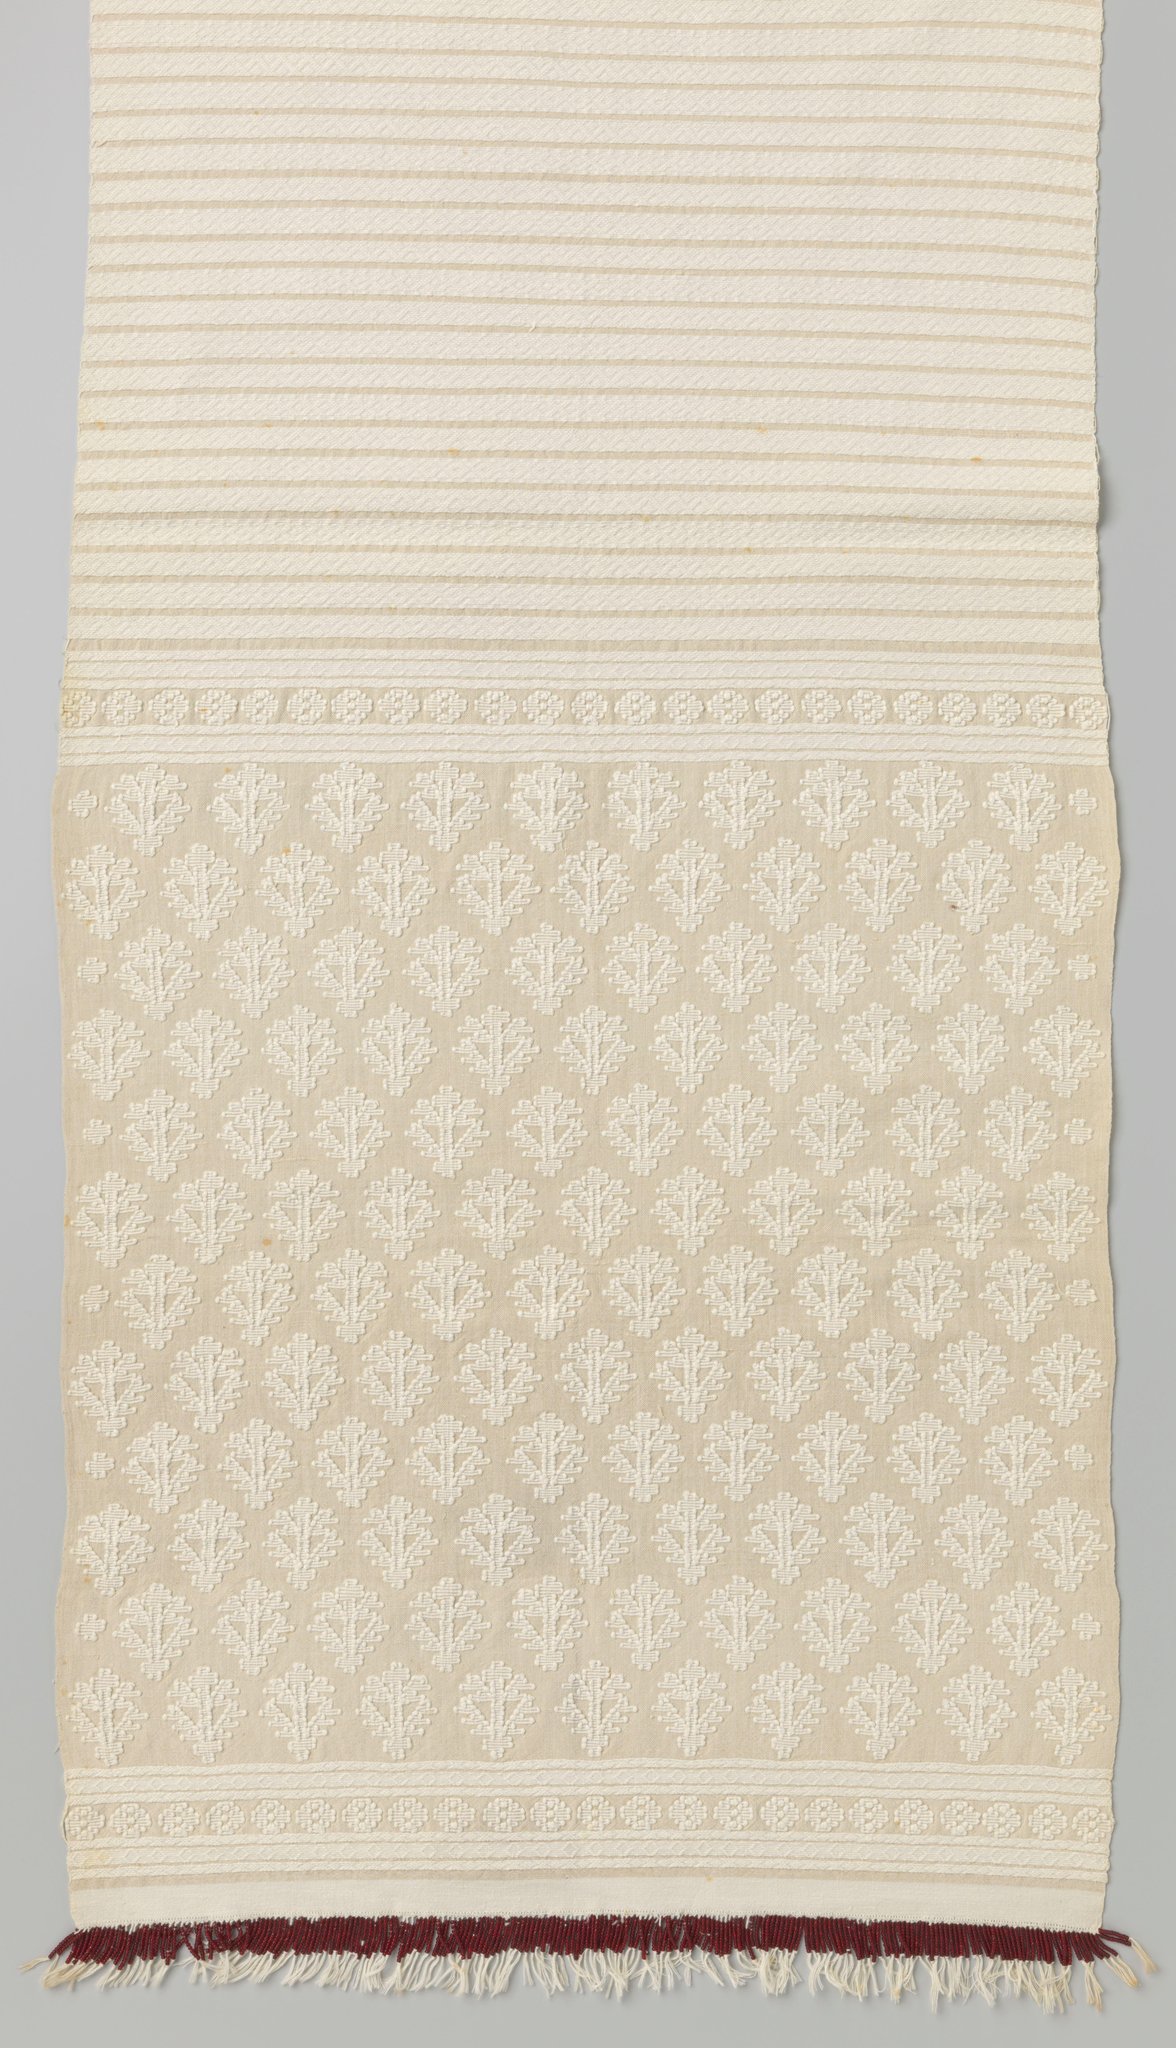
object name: buffetloper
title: Buffetloper van écru katoen, versierd met ingeweven reliëfmotieven met bloemenveldje en smalle strepen; in de weefselfranje zijn donkerrode kralen geregen.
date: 1885-1915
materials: cotton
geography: romania